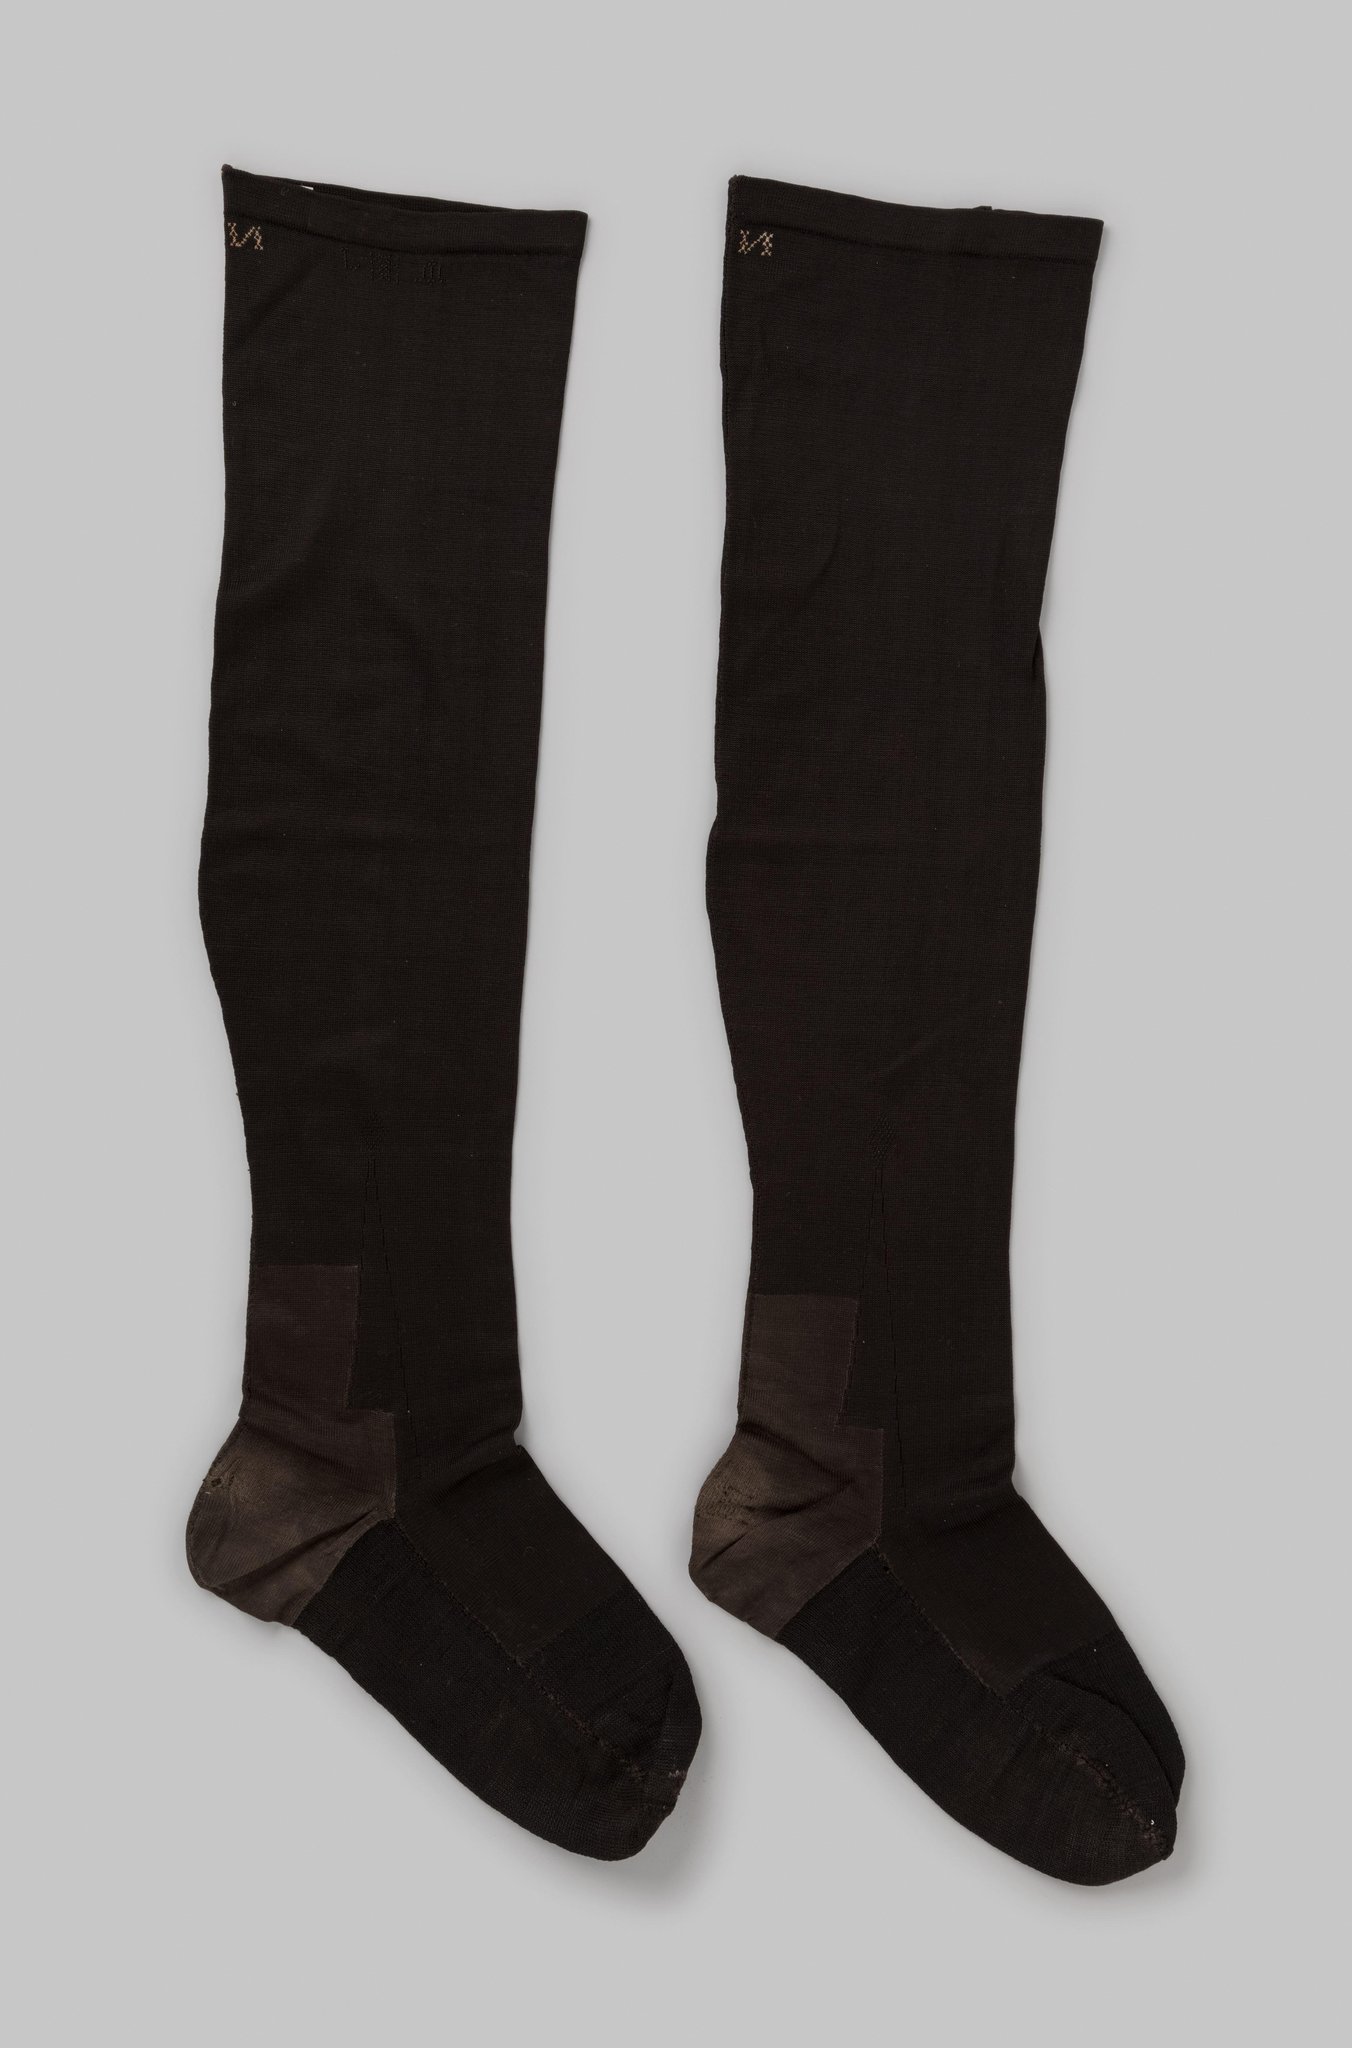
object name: clothing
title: Kous gebreid van effen zwarte glanzend katoen, met voetstukken van wol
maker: Anonymous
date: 1800-1820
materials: cotton, wool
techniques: embroidered, knitting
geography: netherlands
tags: vught, overveen, minister, staatsman, secretaris van staat voor financien, minister van financiën, izaak jean alexandre gogel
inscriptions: initials: ‘N’, inscription: ‘'L' .....’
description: Kous gebreid van effen zwarte glanzend katoen, met voetstukken van wol. Naad middenachter, geborduurde diamantvorm op de klink. Smalle boord. In ecrukleurig kruissteek de letter 'N', en een meegebreid opschrift: 'L', drie kruizen onder elkaar en een 'M'vorm.